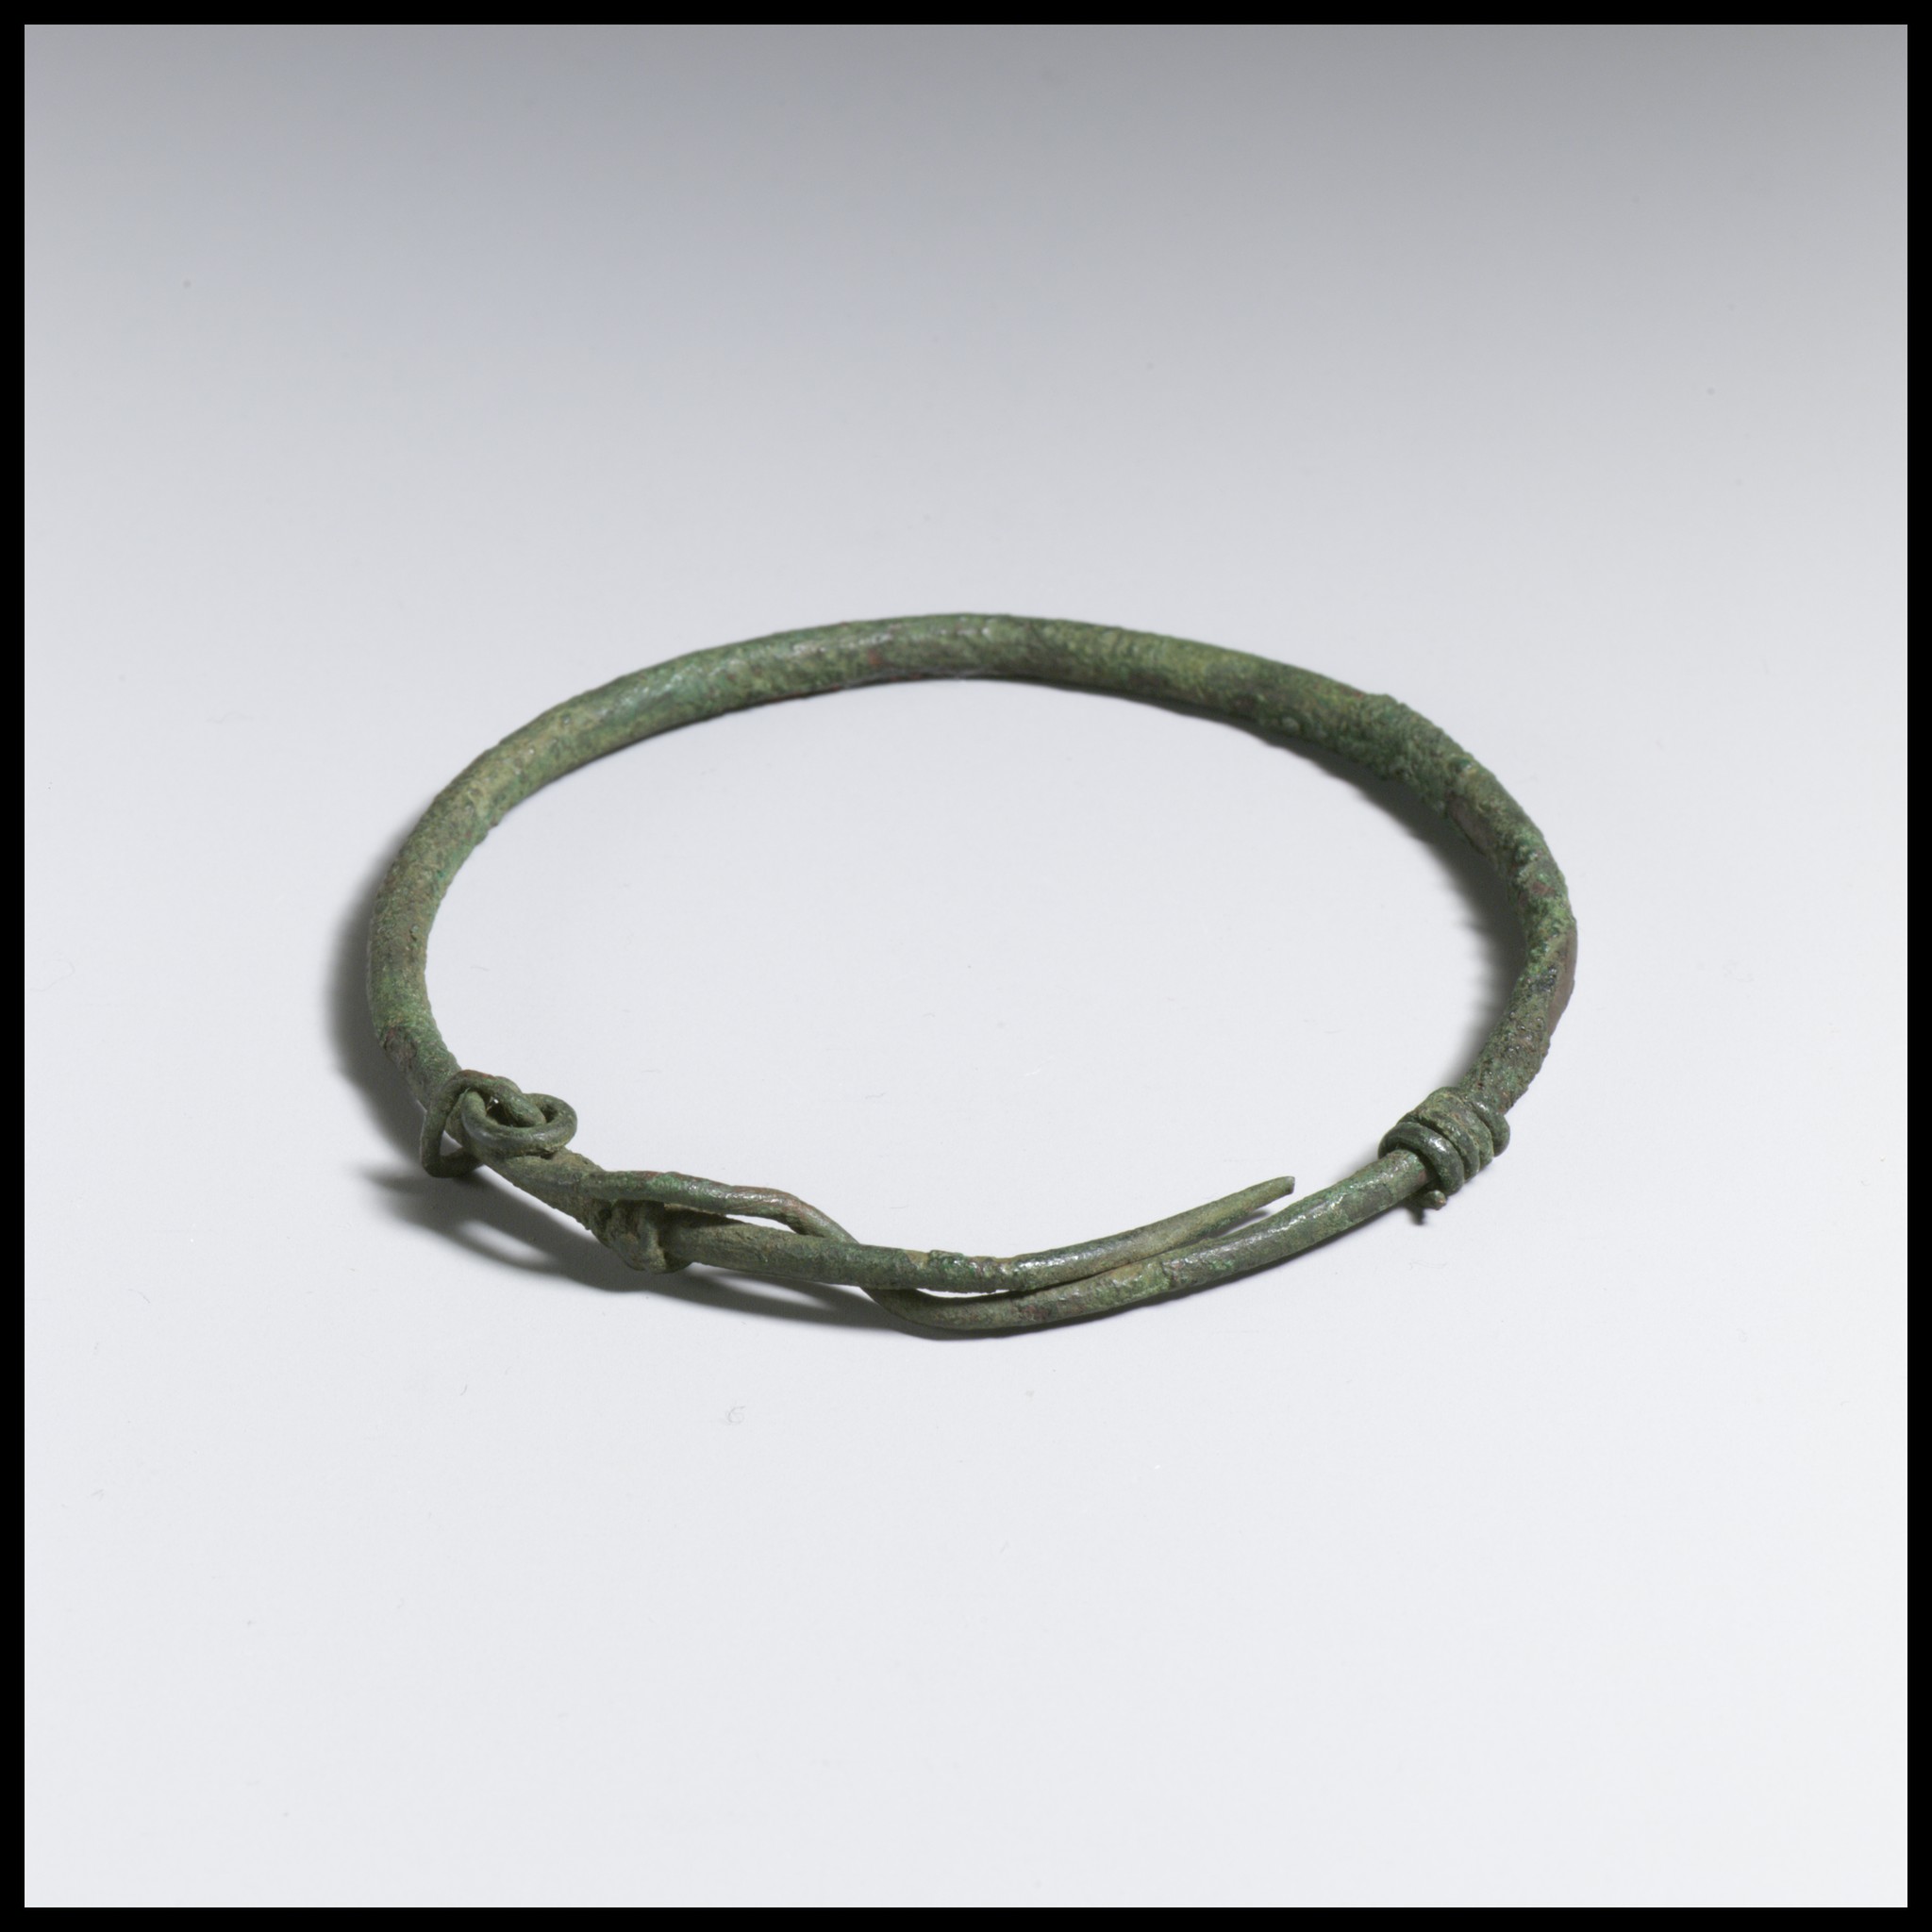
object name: bracelet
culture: roman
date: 670 BCE-330 CE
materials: bronze